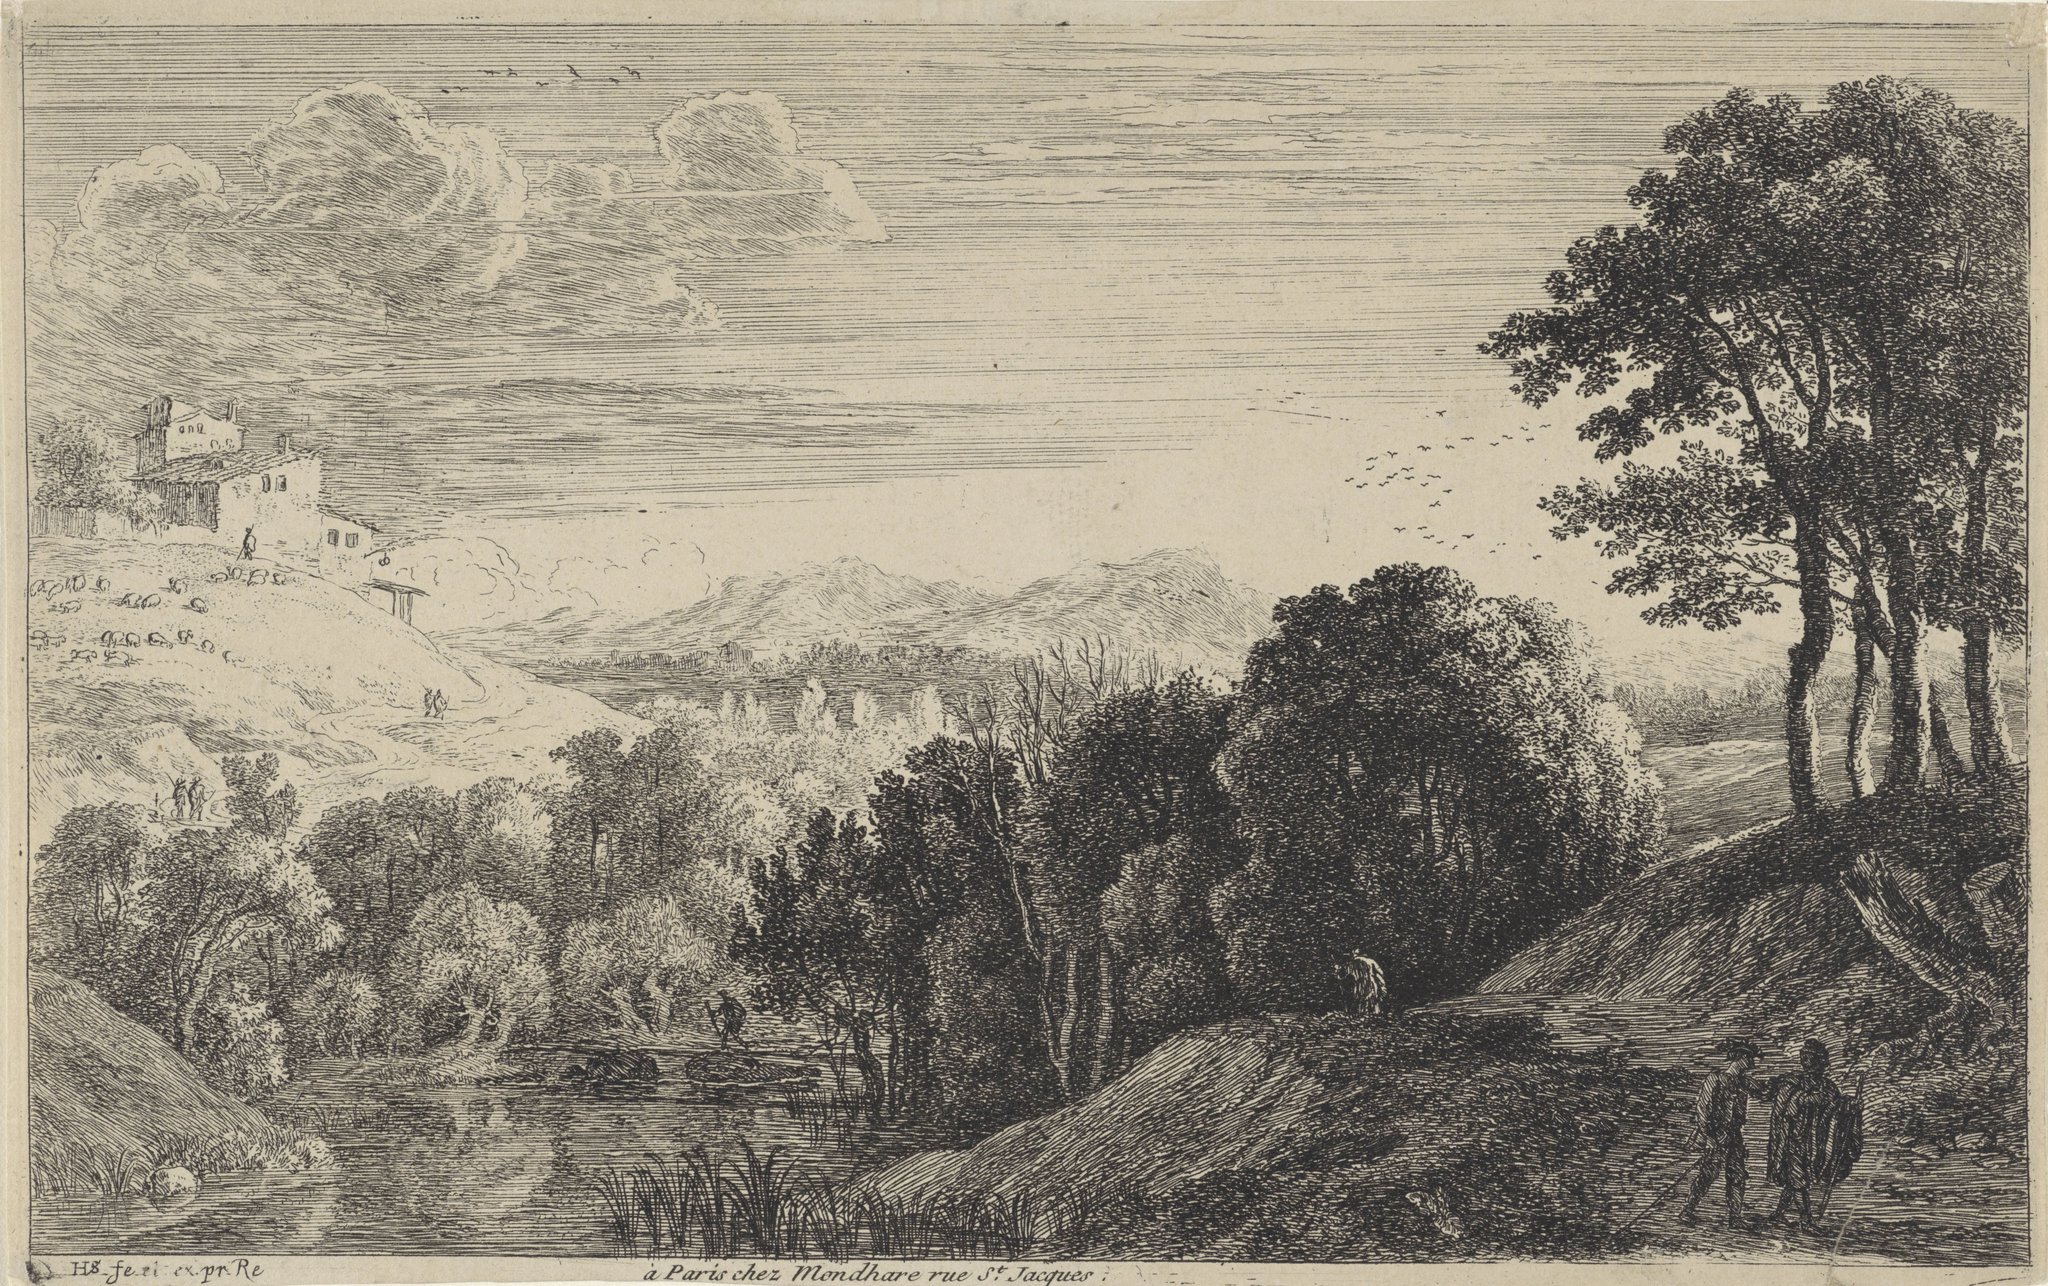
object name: print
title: Heuvellandschappen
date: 1759-1784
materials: paper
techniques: etching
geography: paris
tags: river, herding, herdsman, herdswoman, shepherd, shepherdess, cowherd, etc., rural housing, e.g. country-house, villa, cottage, (high) hill, sheep, sunset, 'en route', traveller under way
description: Op een pad langs de rivier lopen enkele wandelaars. Een wandelaar steekt de rivier over en in de verte ligt een gebouw op een heuvel. Bij het gebouw hoedt een herder een kudde schapen.